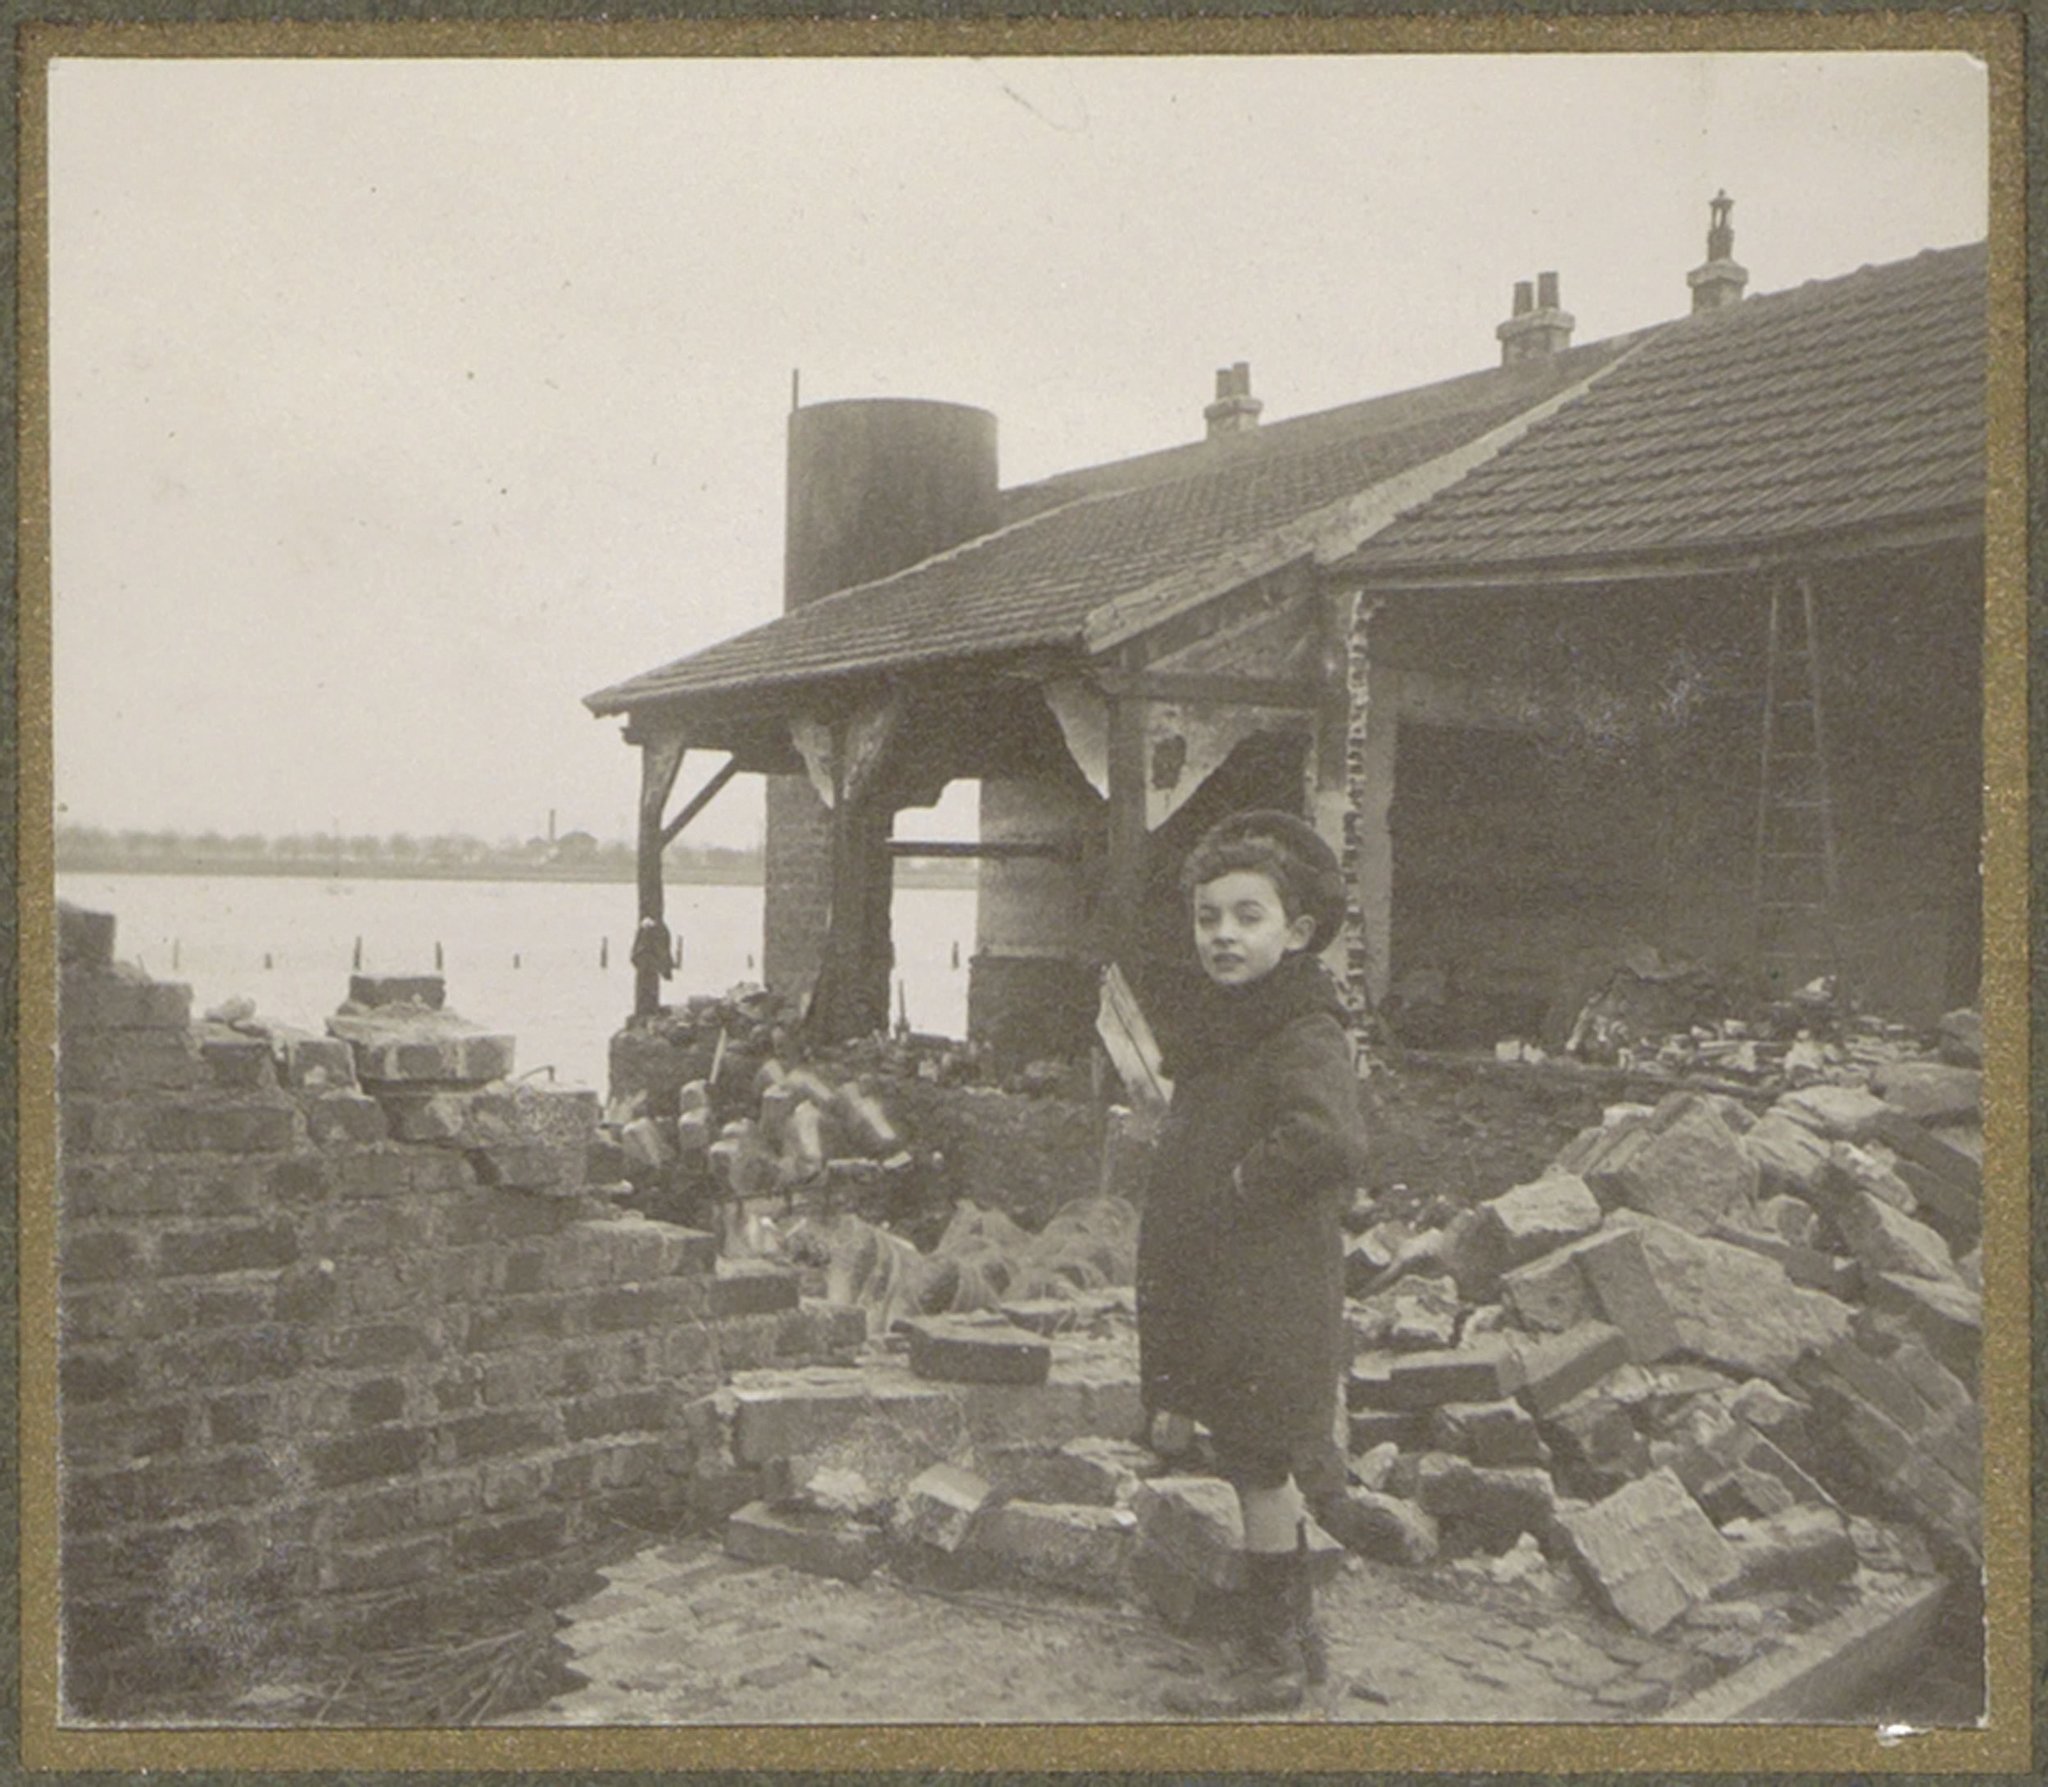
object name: photograph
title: Kind bij een verwoest gebouw in een overstroomde buitenwijk van Parijs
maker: g. dangereux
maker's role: fotograaf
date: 1901-1910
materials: photographic support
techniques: matte daylight collodion silver print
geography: paris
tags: flood (+ landscape with figures, staffage), child, paris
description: Onderdeel van fotoalbum overstroming Parijs en voorsteden 1910.